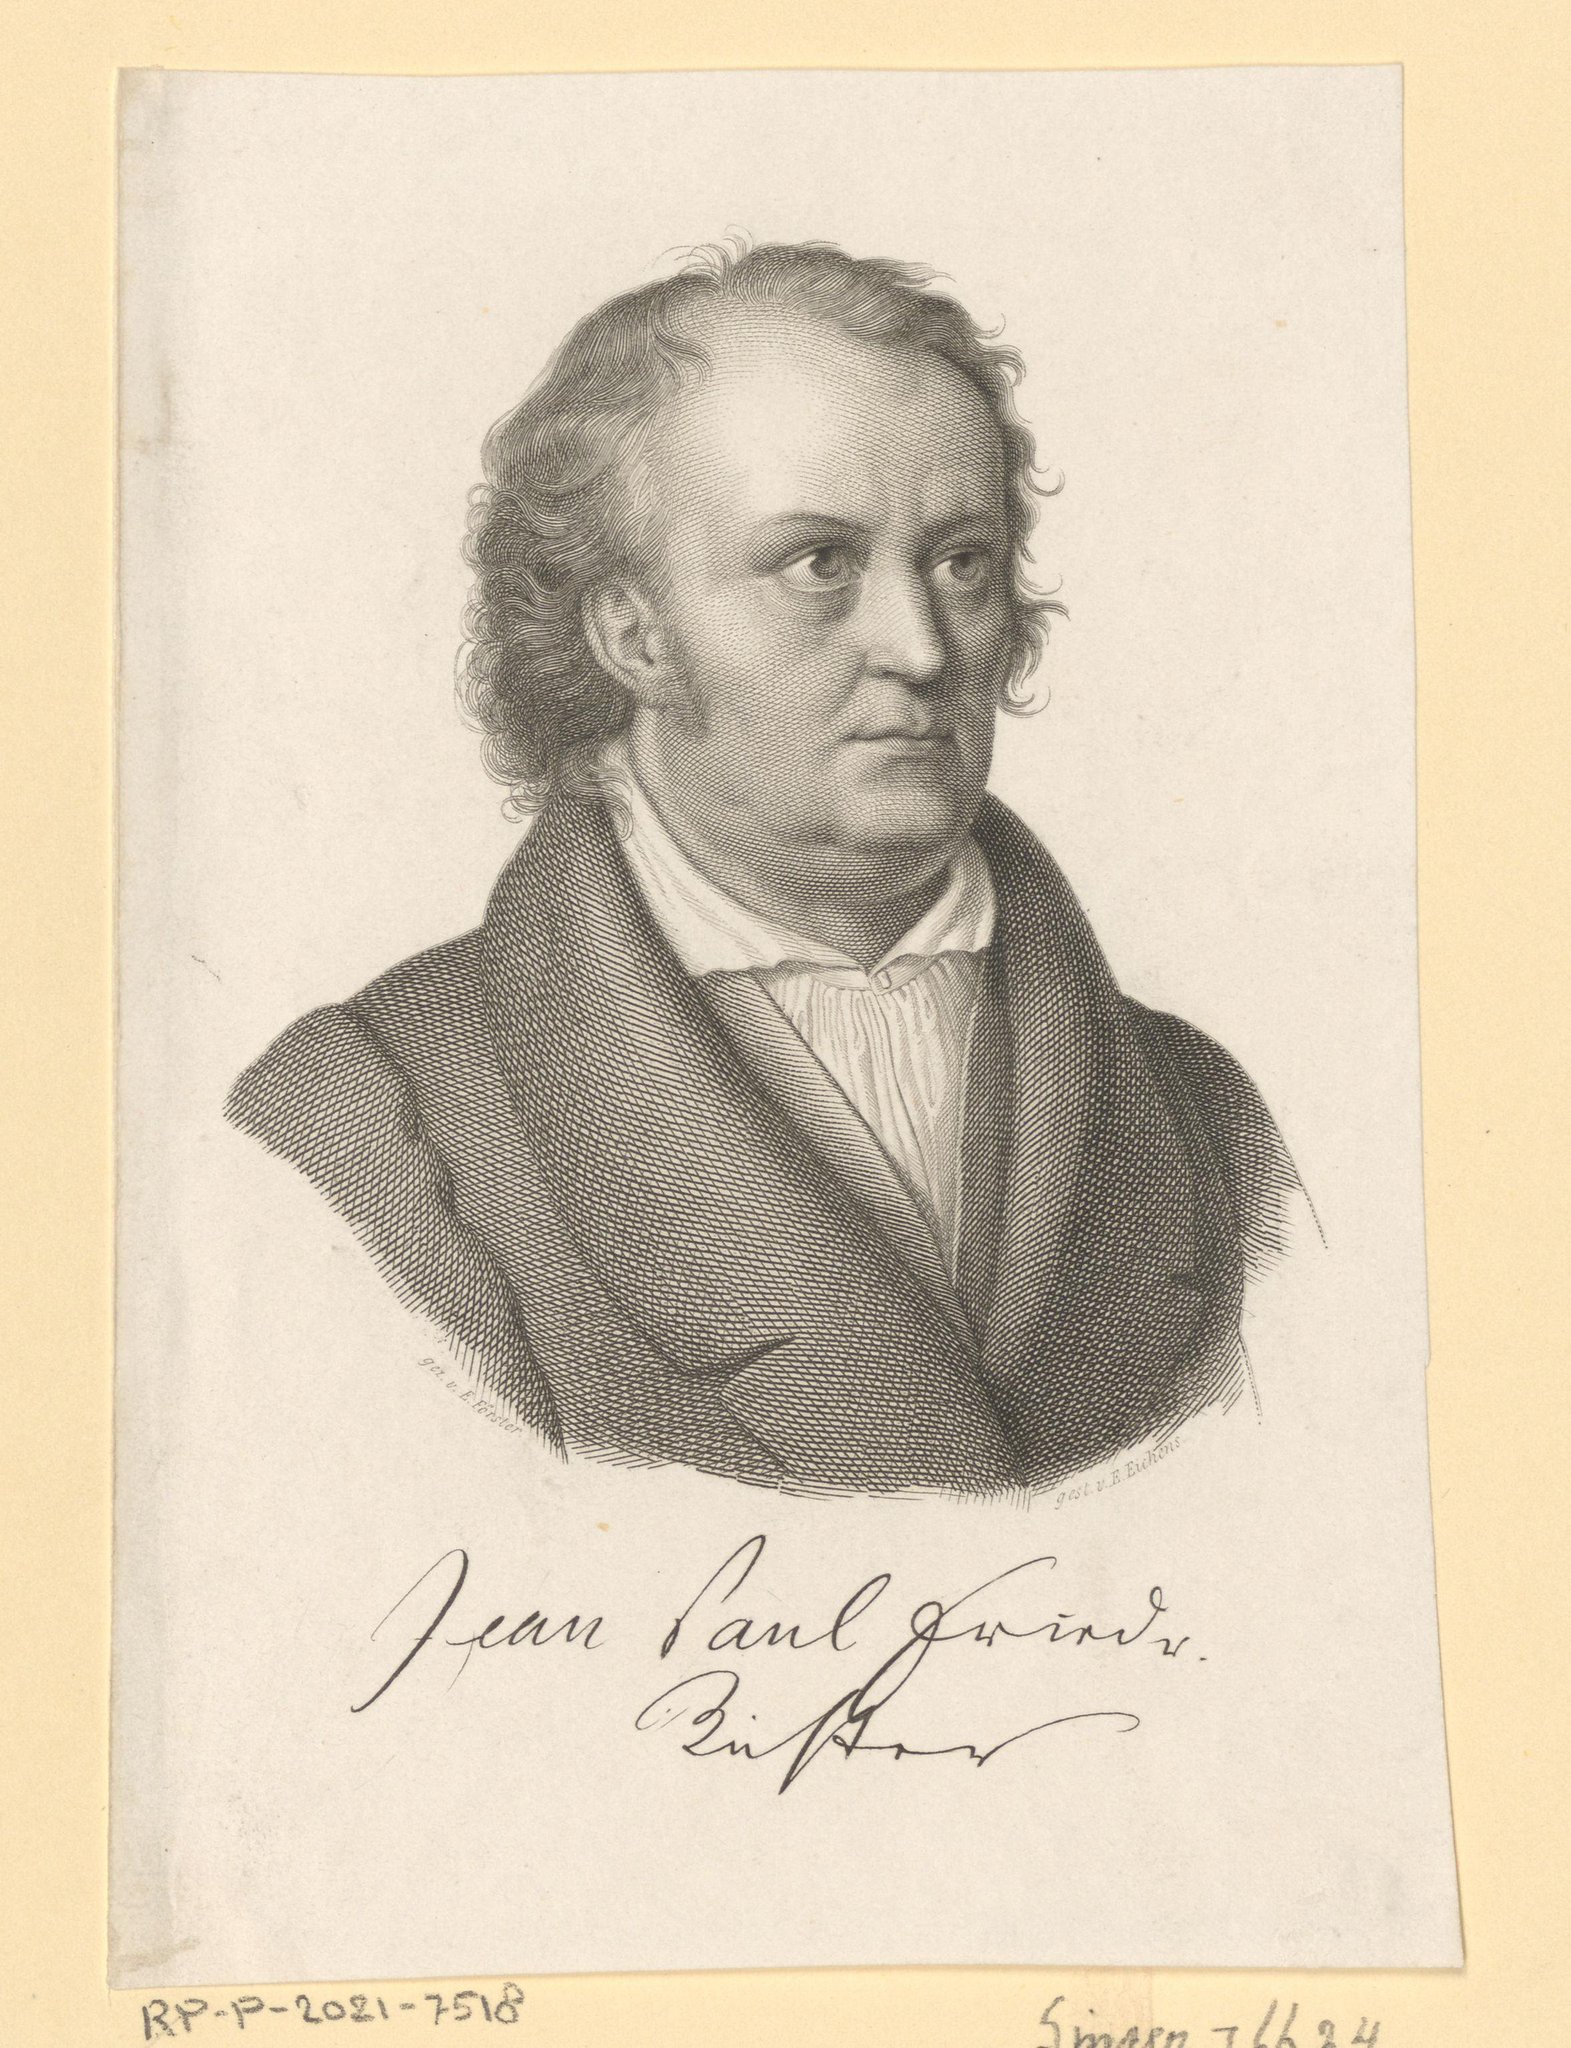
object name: print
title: Portret van Jean Paul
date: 1814-1877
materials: paper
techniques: etching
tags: jean paul, historical persons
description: Onder het portret een facsimile van de handtekening van de geportretteerde.